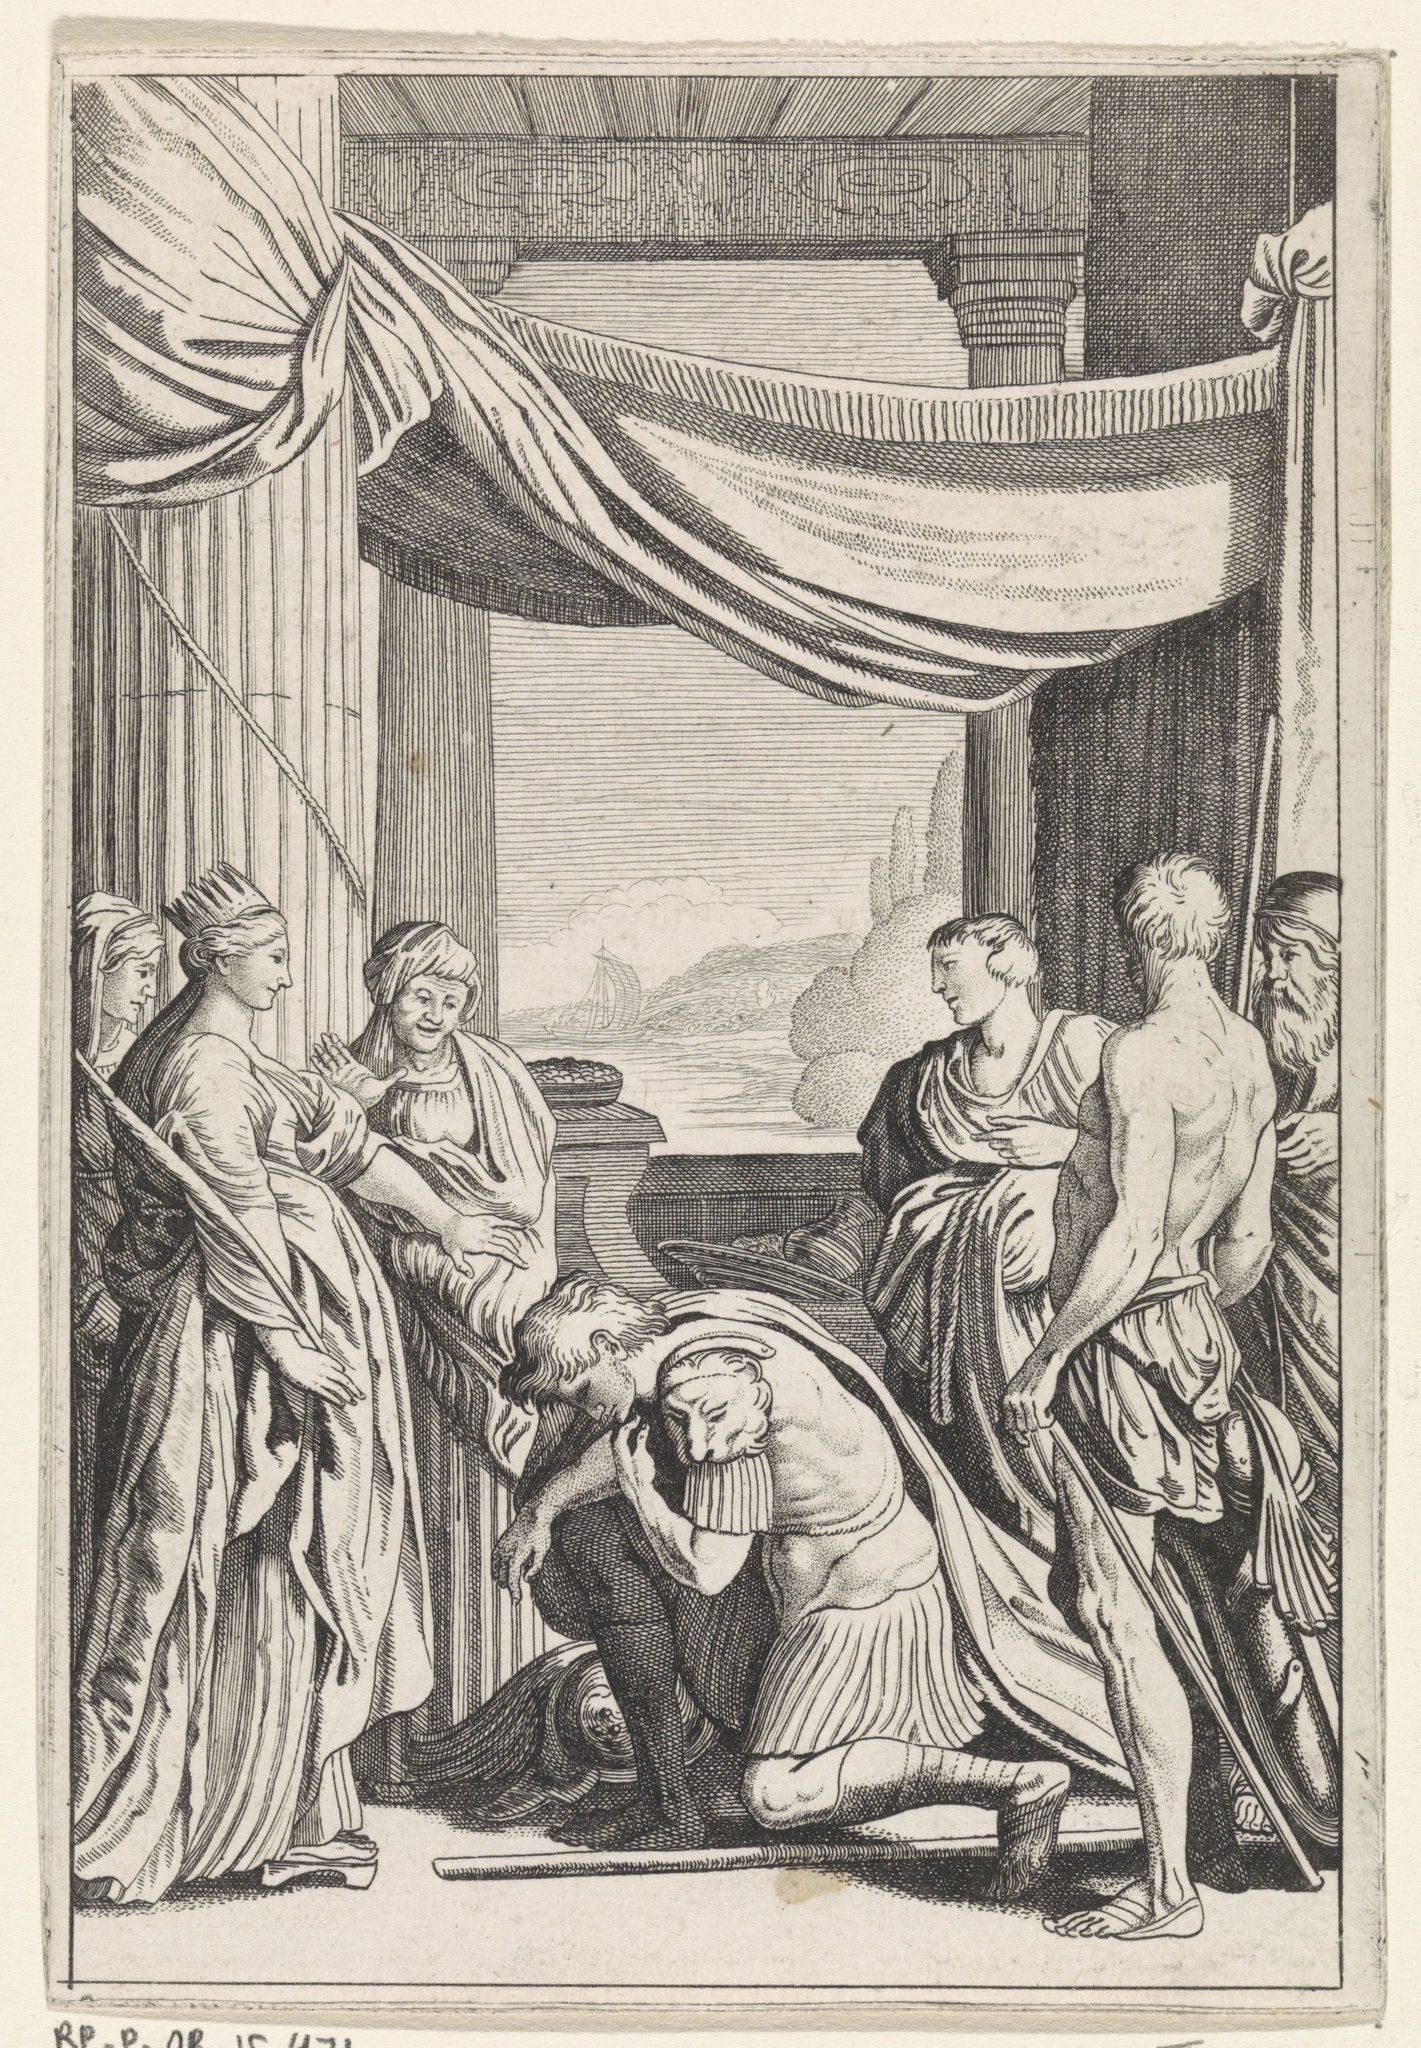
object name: print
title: Aeneas knielend door Dido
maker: jan van de velde (ii)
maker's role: draughtsman, painter, print maker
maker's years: 1593-1641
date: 1621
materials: paper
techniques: etching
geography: northern netherlands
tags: the meeting of aeneas and dido; when he approaches her throne, the cloud enveloping him and achates vanishes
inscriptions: collector's mark: Lugt 240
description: Prent ook gebruikt als boekillustratie in: Houwaert, Johan Baptista. Den handel der amoureusheyt inhoudende vier poetische spelen. Rotterdam: Jan van Waesberghe III, 1621.